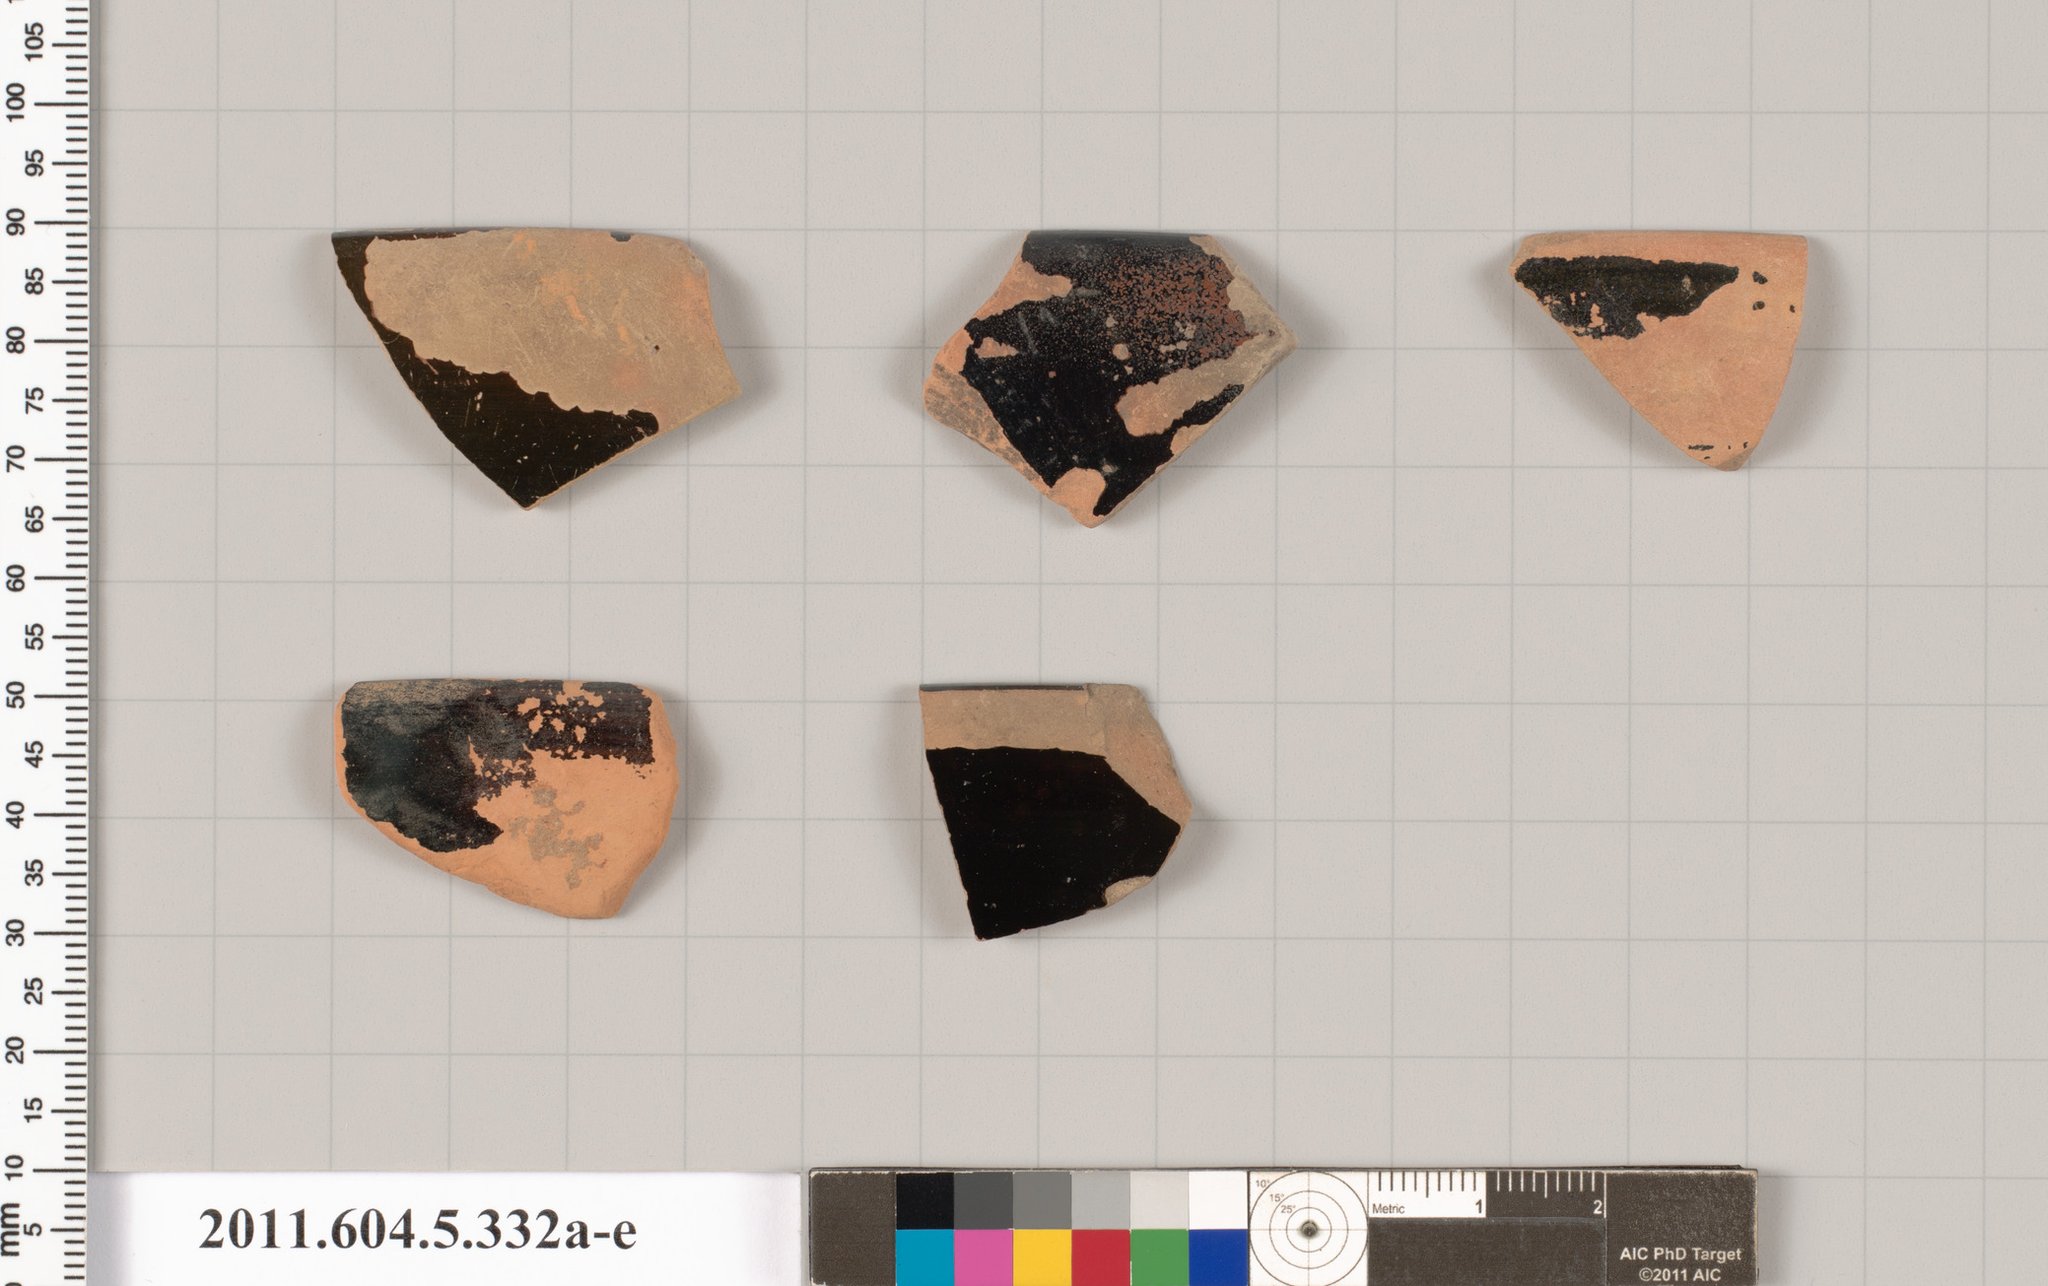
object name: kylix fragment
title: Terracotta rim fragments of kylikes (drinking cups)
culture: greek, attic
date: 600-401 BCE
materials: terracotta